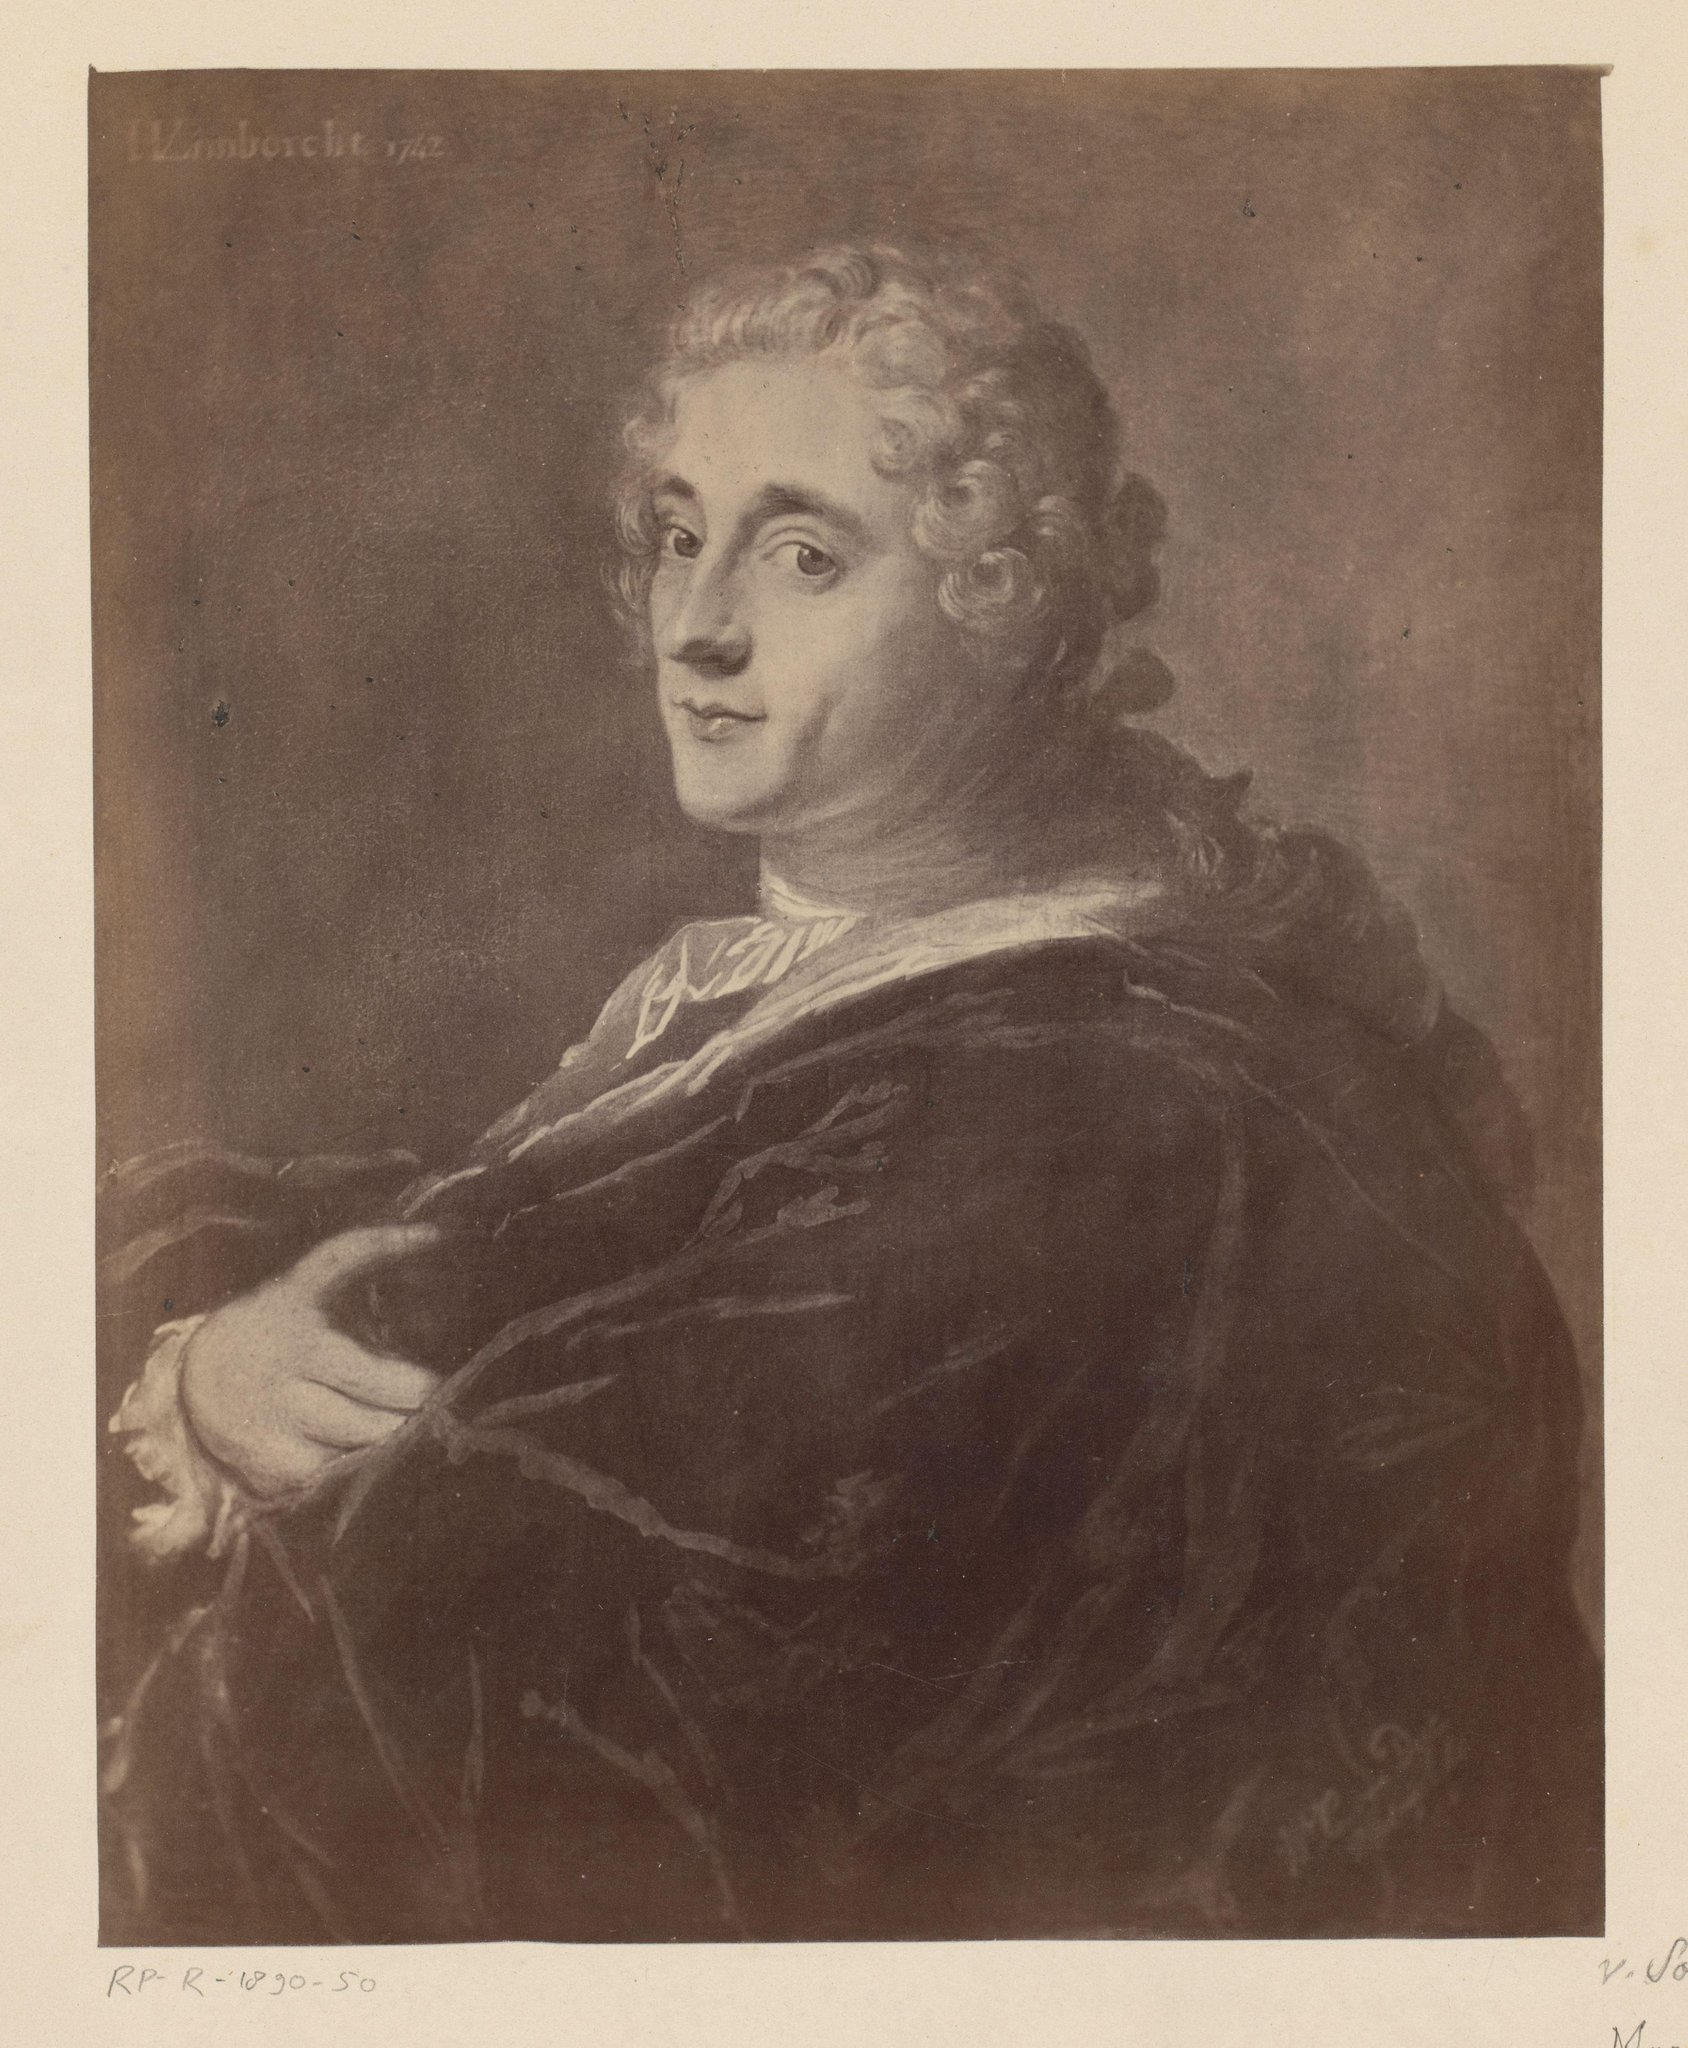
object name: photograph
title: P. Lÿonet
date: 1851-1890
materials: cardboard, paper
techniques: albumen print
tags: maastricht, print maker, draughtsman, pieter lyonet, historical persons, picture, painting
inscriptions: inscription: ‘Aanw: 1890/ decl: F. Muller’, inscription: ‘v. Someren 3384/ Moes 471D/ als&prt/ natuurkundige en graveur/ H. van Limborch pinxit/ P. Lyonet/ 1707-1789’, collector's mark: Lugt 2228a